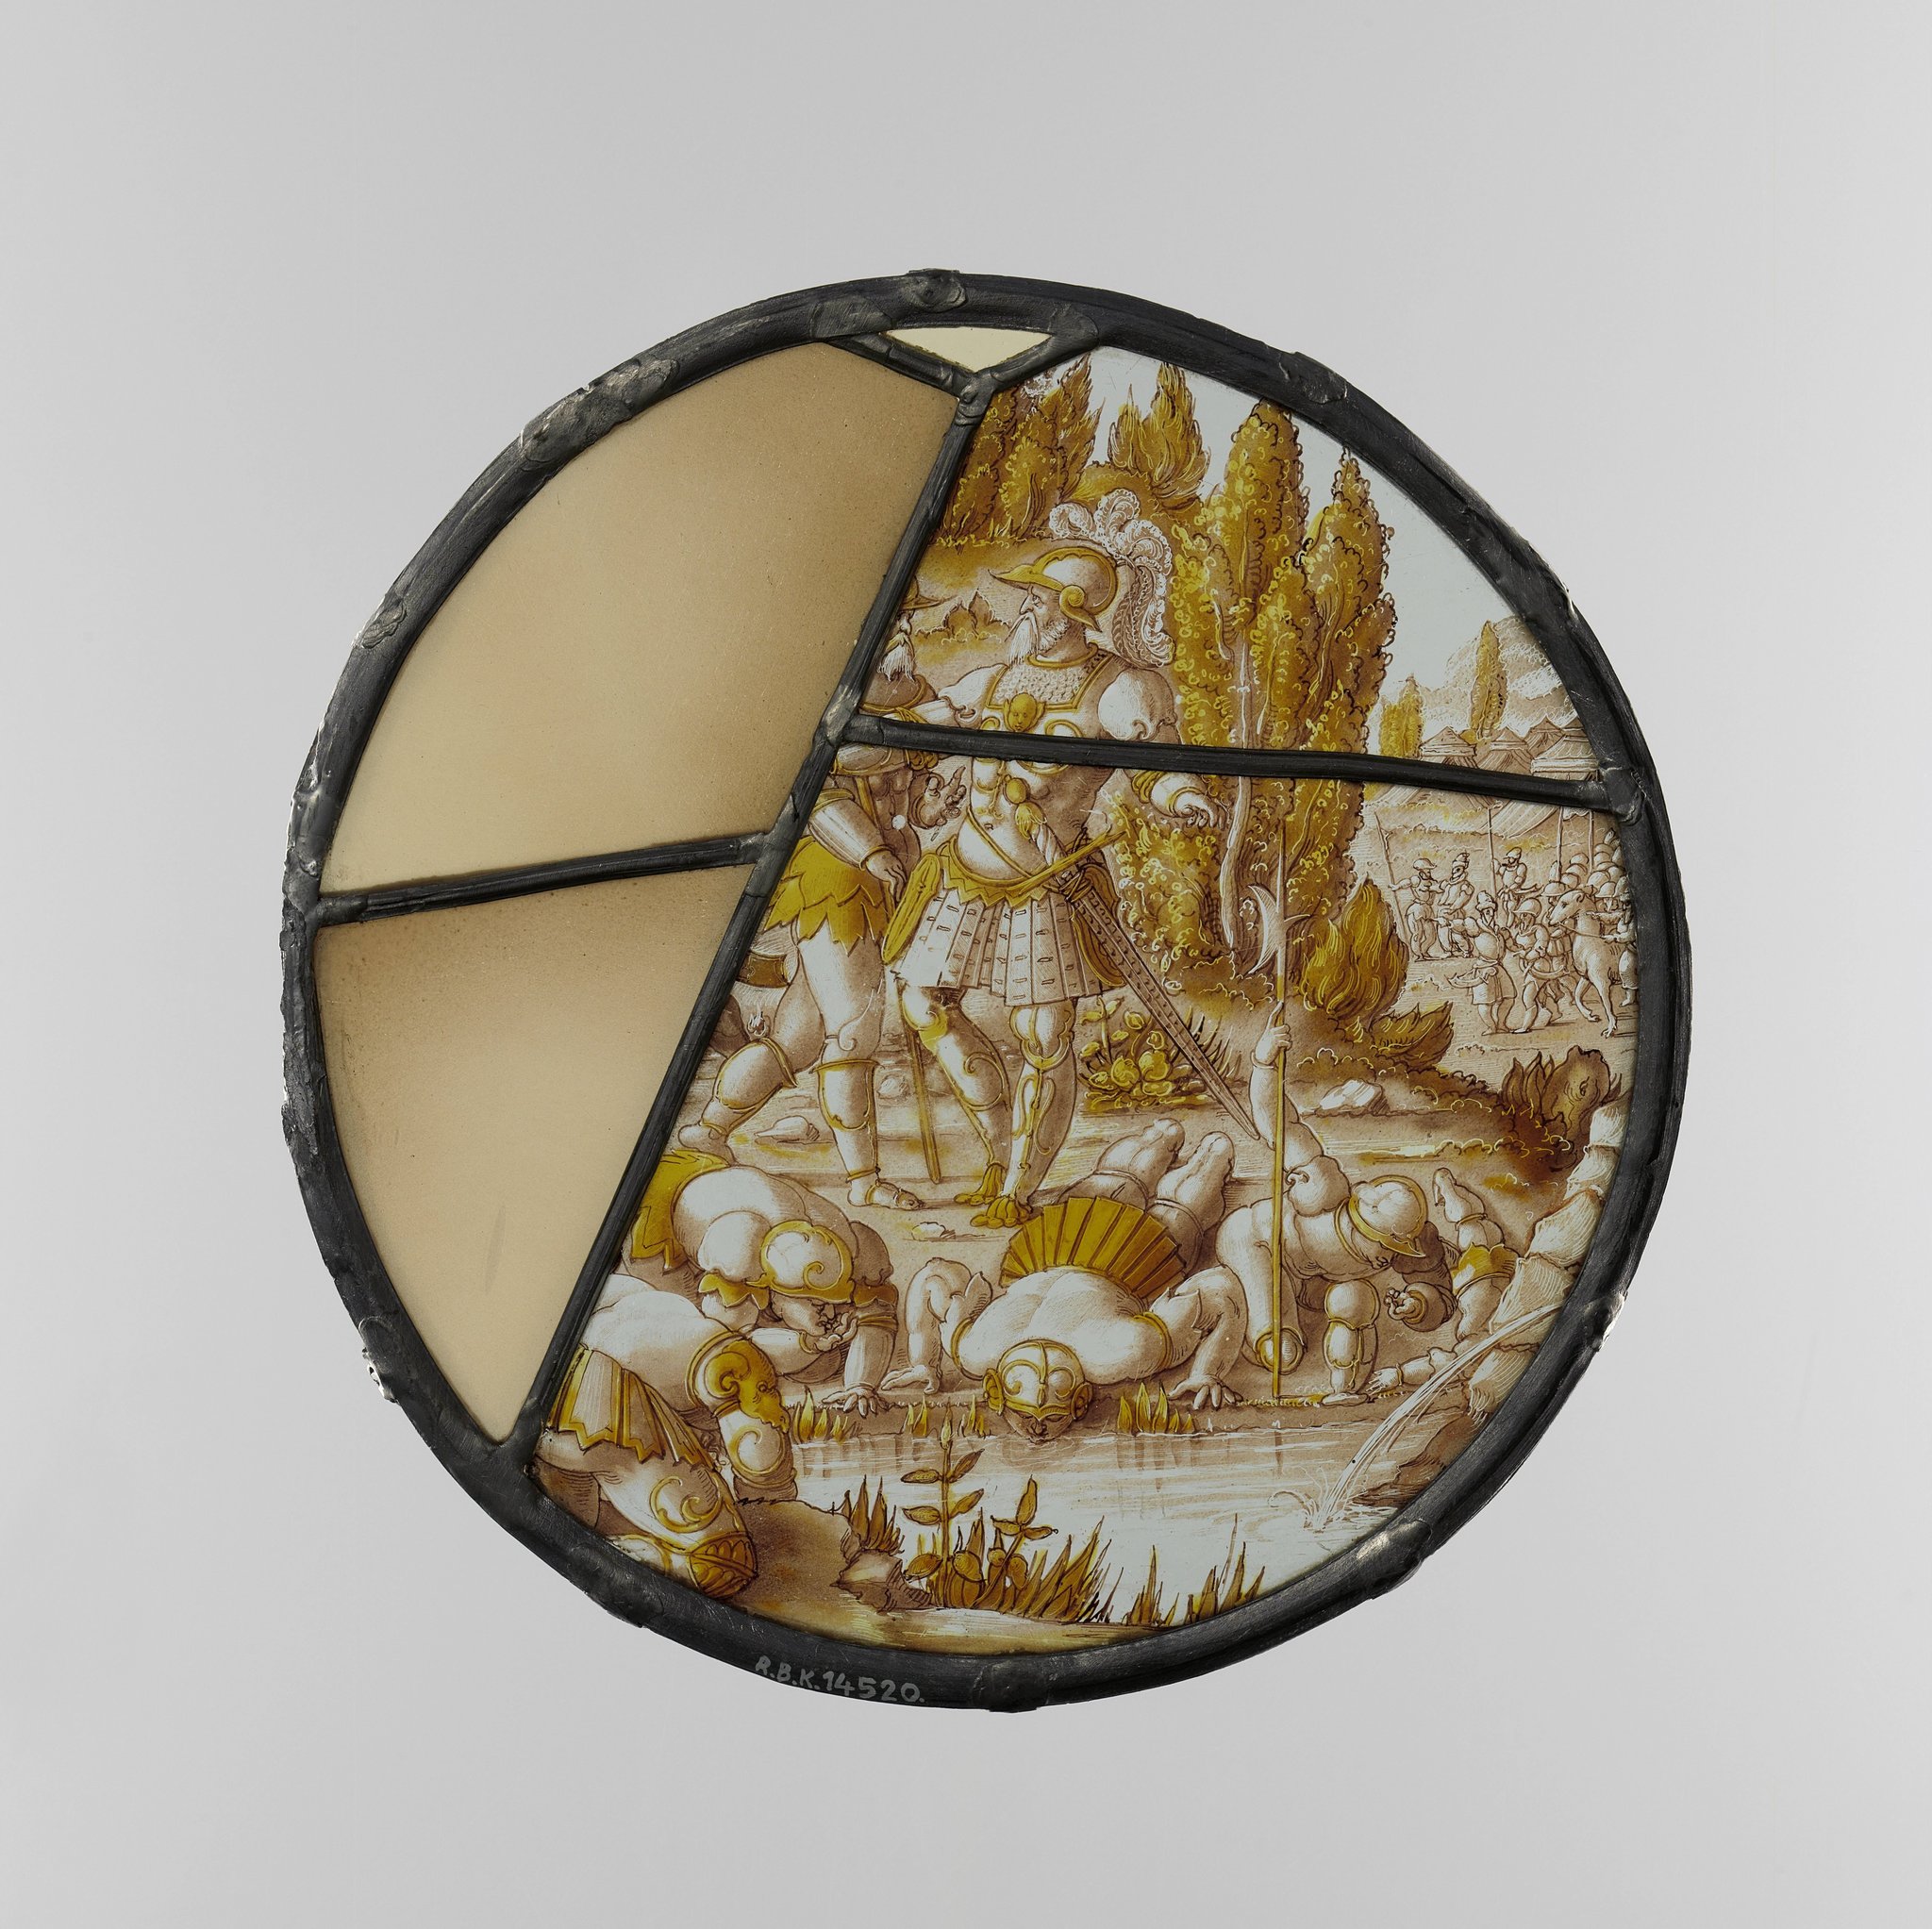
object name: light window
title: Ruit met Gideon en zijn soldaten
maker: Anonymous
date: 1500-1550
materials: glass, lead, pigment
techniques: leading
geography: southern netherlands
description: Een ronde gebrandschilderde ruit met de voorstelling van Gideon en zijn soldaten. Op de voorgrond de fontein van Harod met vier soldaten. Gideon is met sabel in sprekende houding weergegeven. Op de achtergrond tenten en krijgslieden.